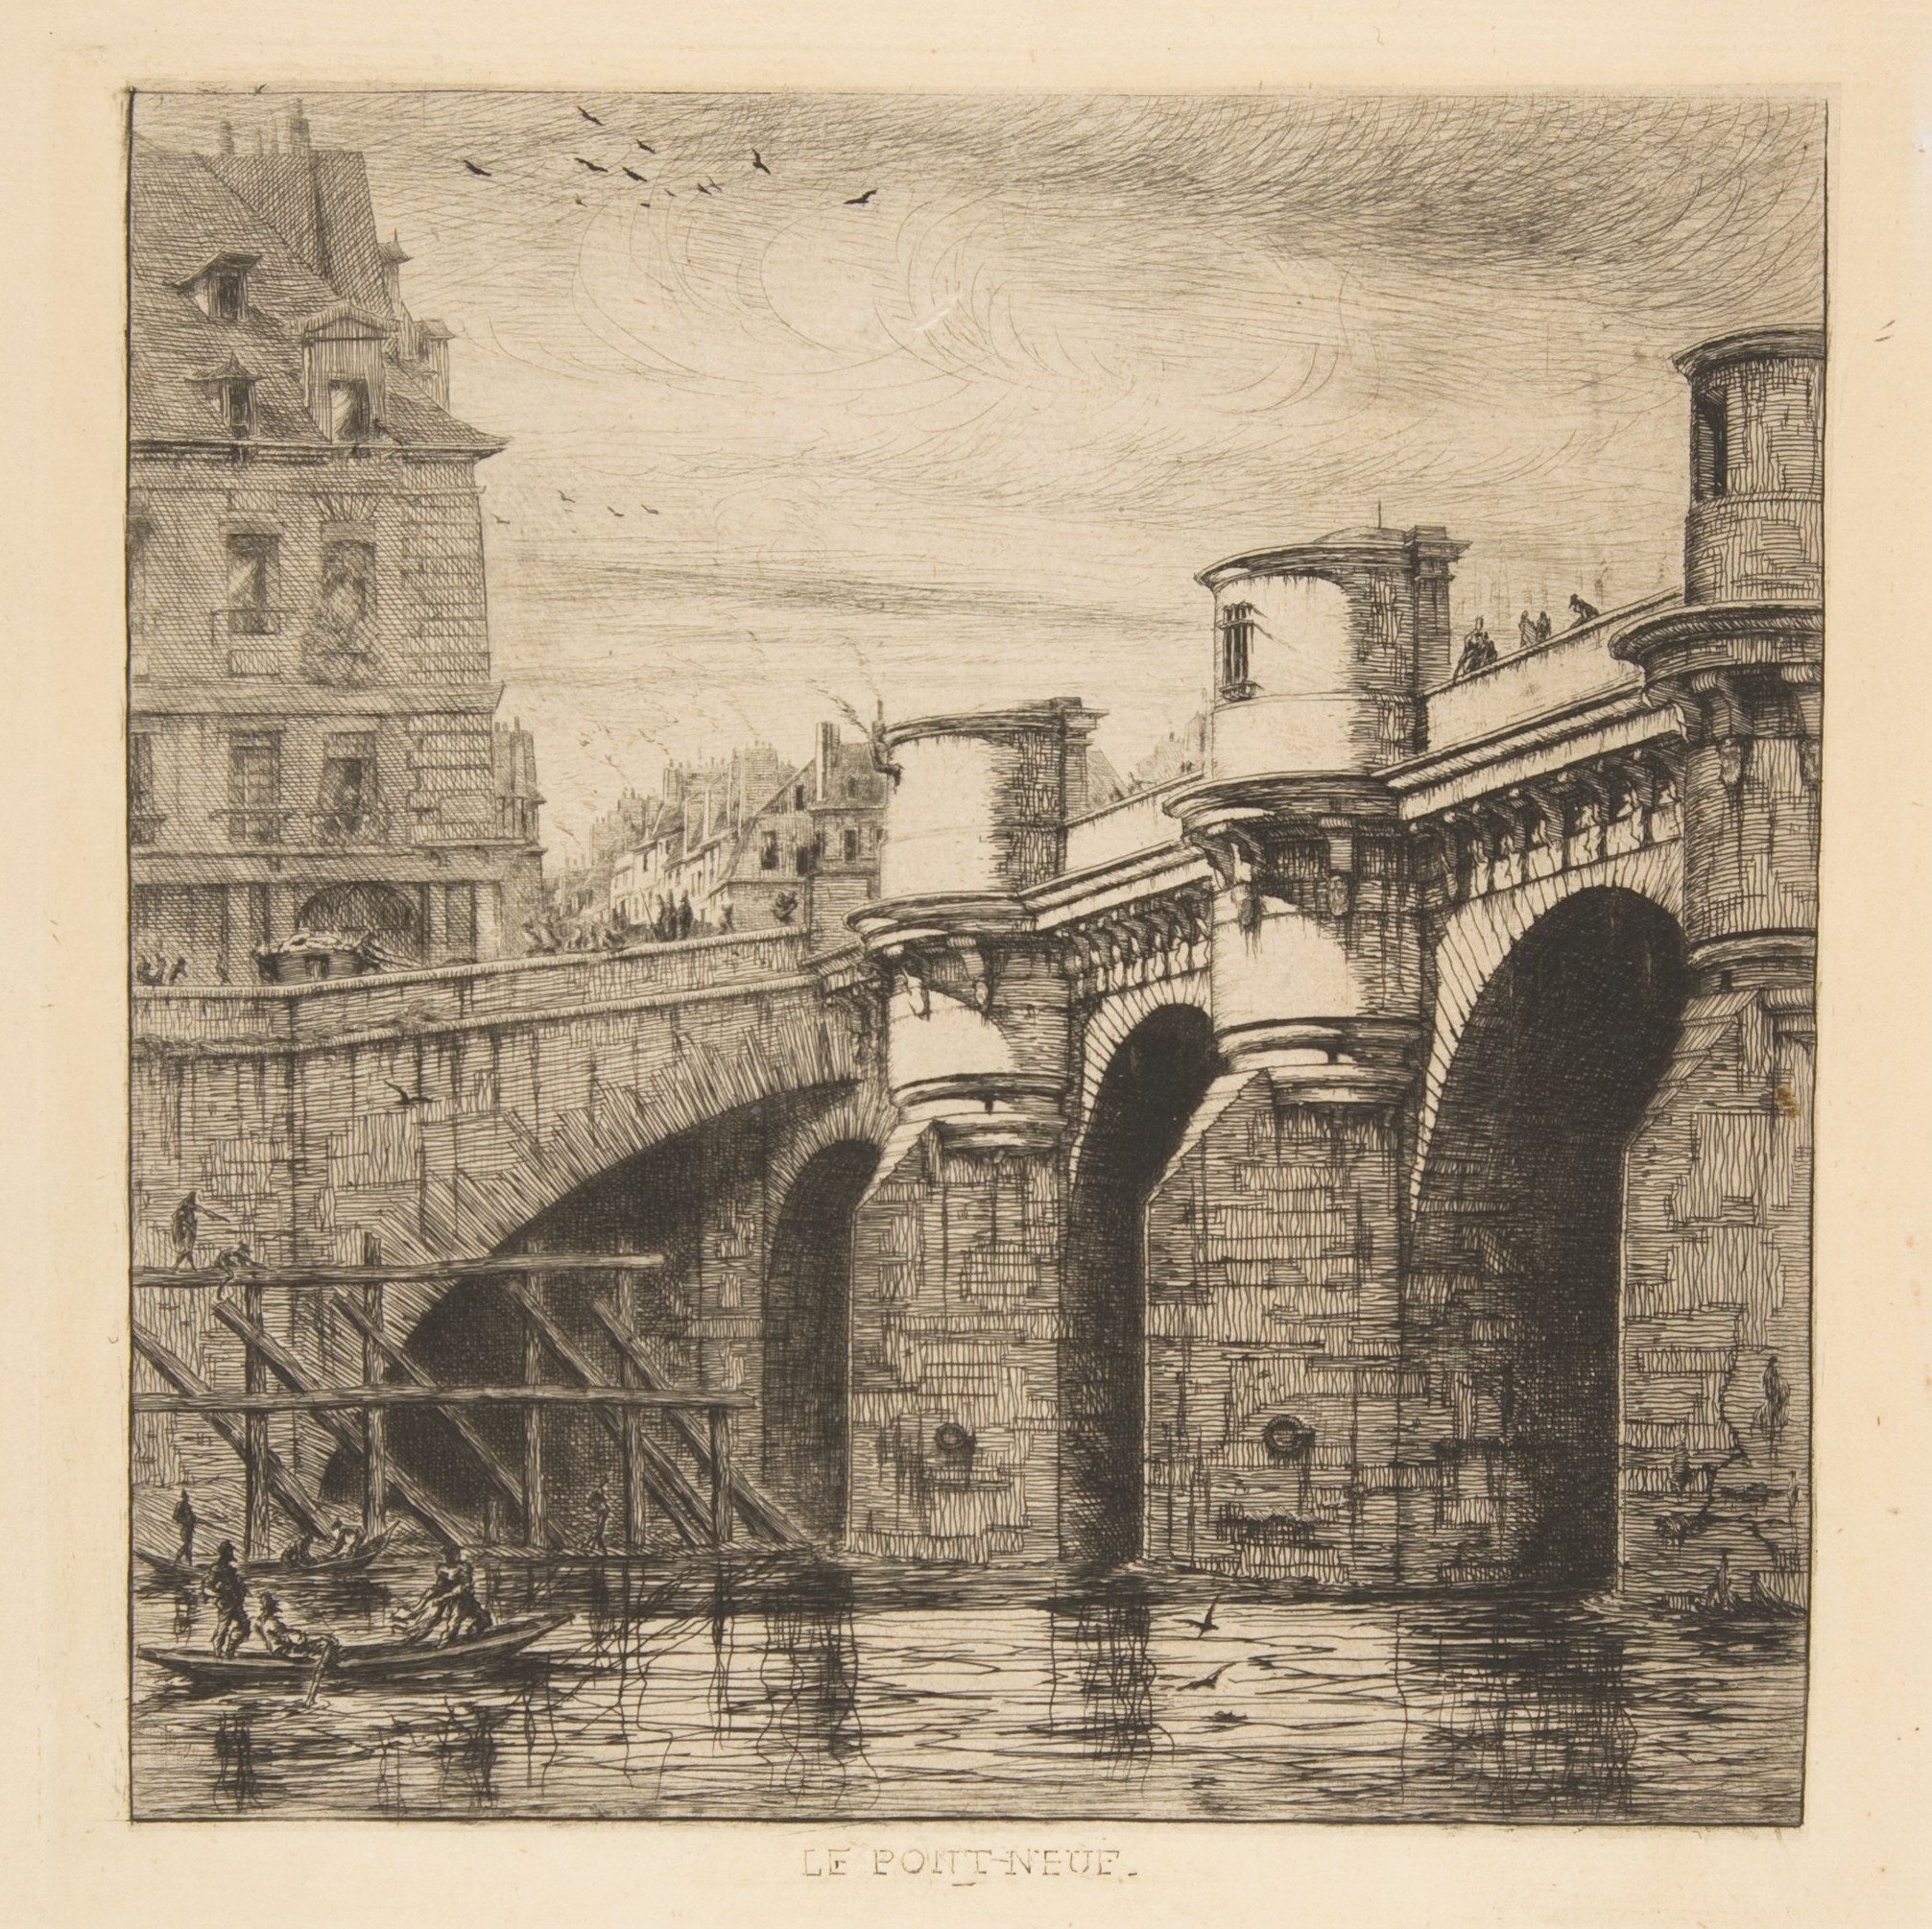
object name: print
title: Pont-Neuf, Paris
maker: charles meryon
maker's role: artist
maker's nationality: french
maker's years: 1821-1868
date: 1853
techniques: drypoint, etching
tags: buildings,bridges,boats,paris